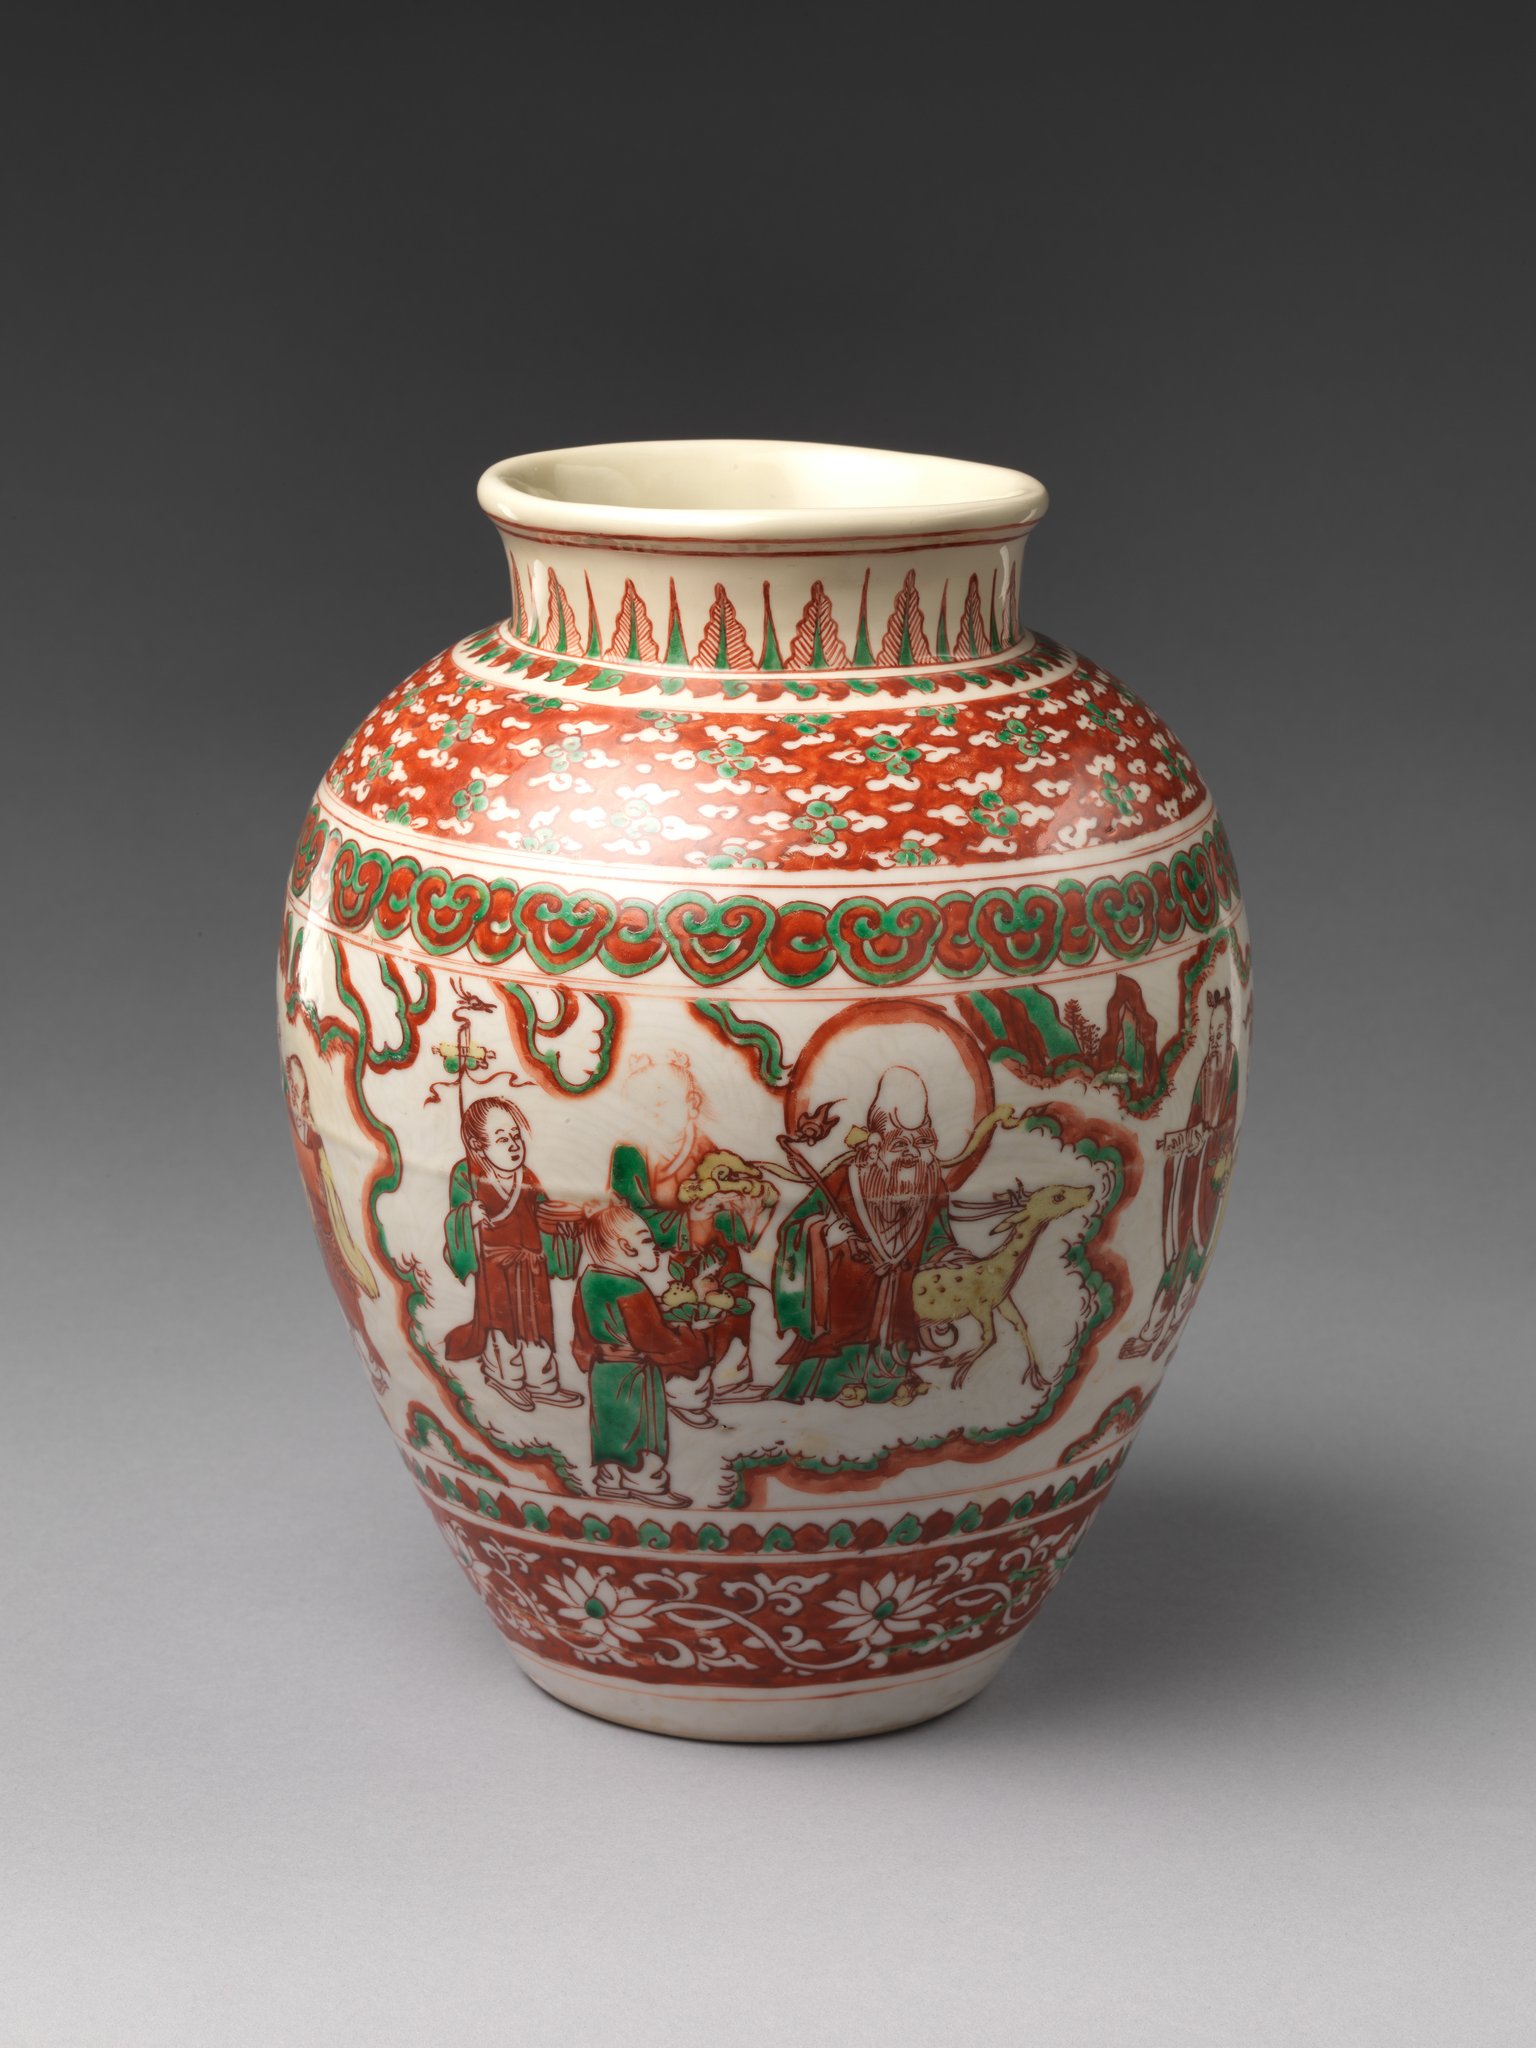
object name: jar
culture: chinese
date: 1522-1566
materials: enamel, porcelain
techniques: incising, polychrome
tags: men,deer,flowers